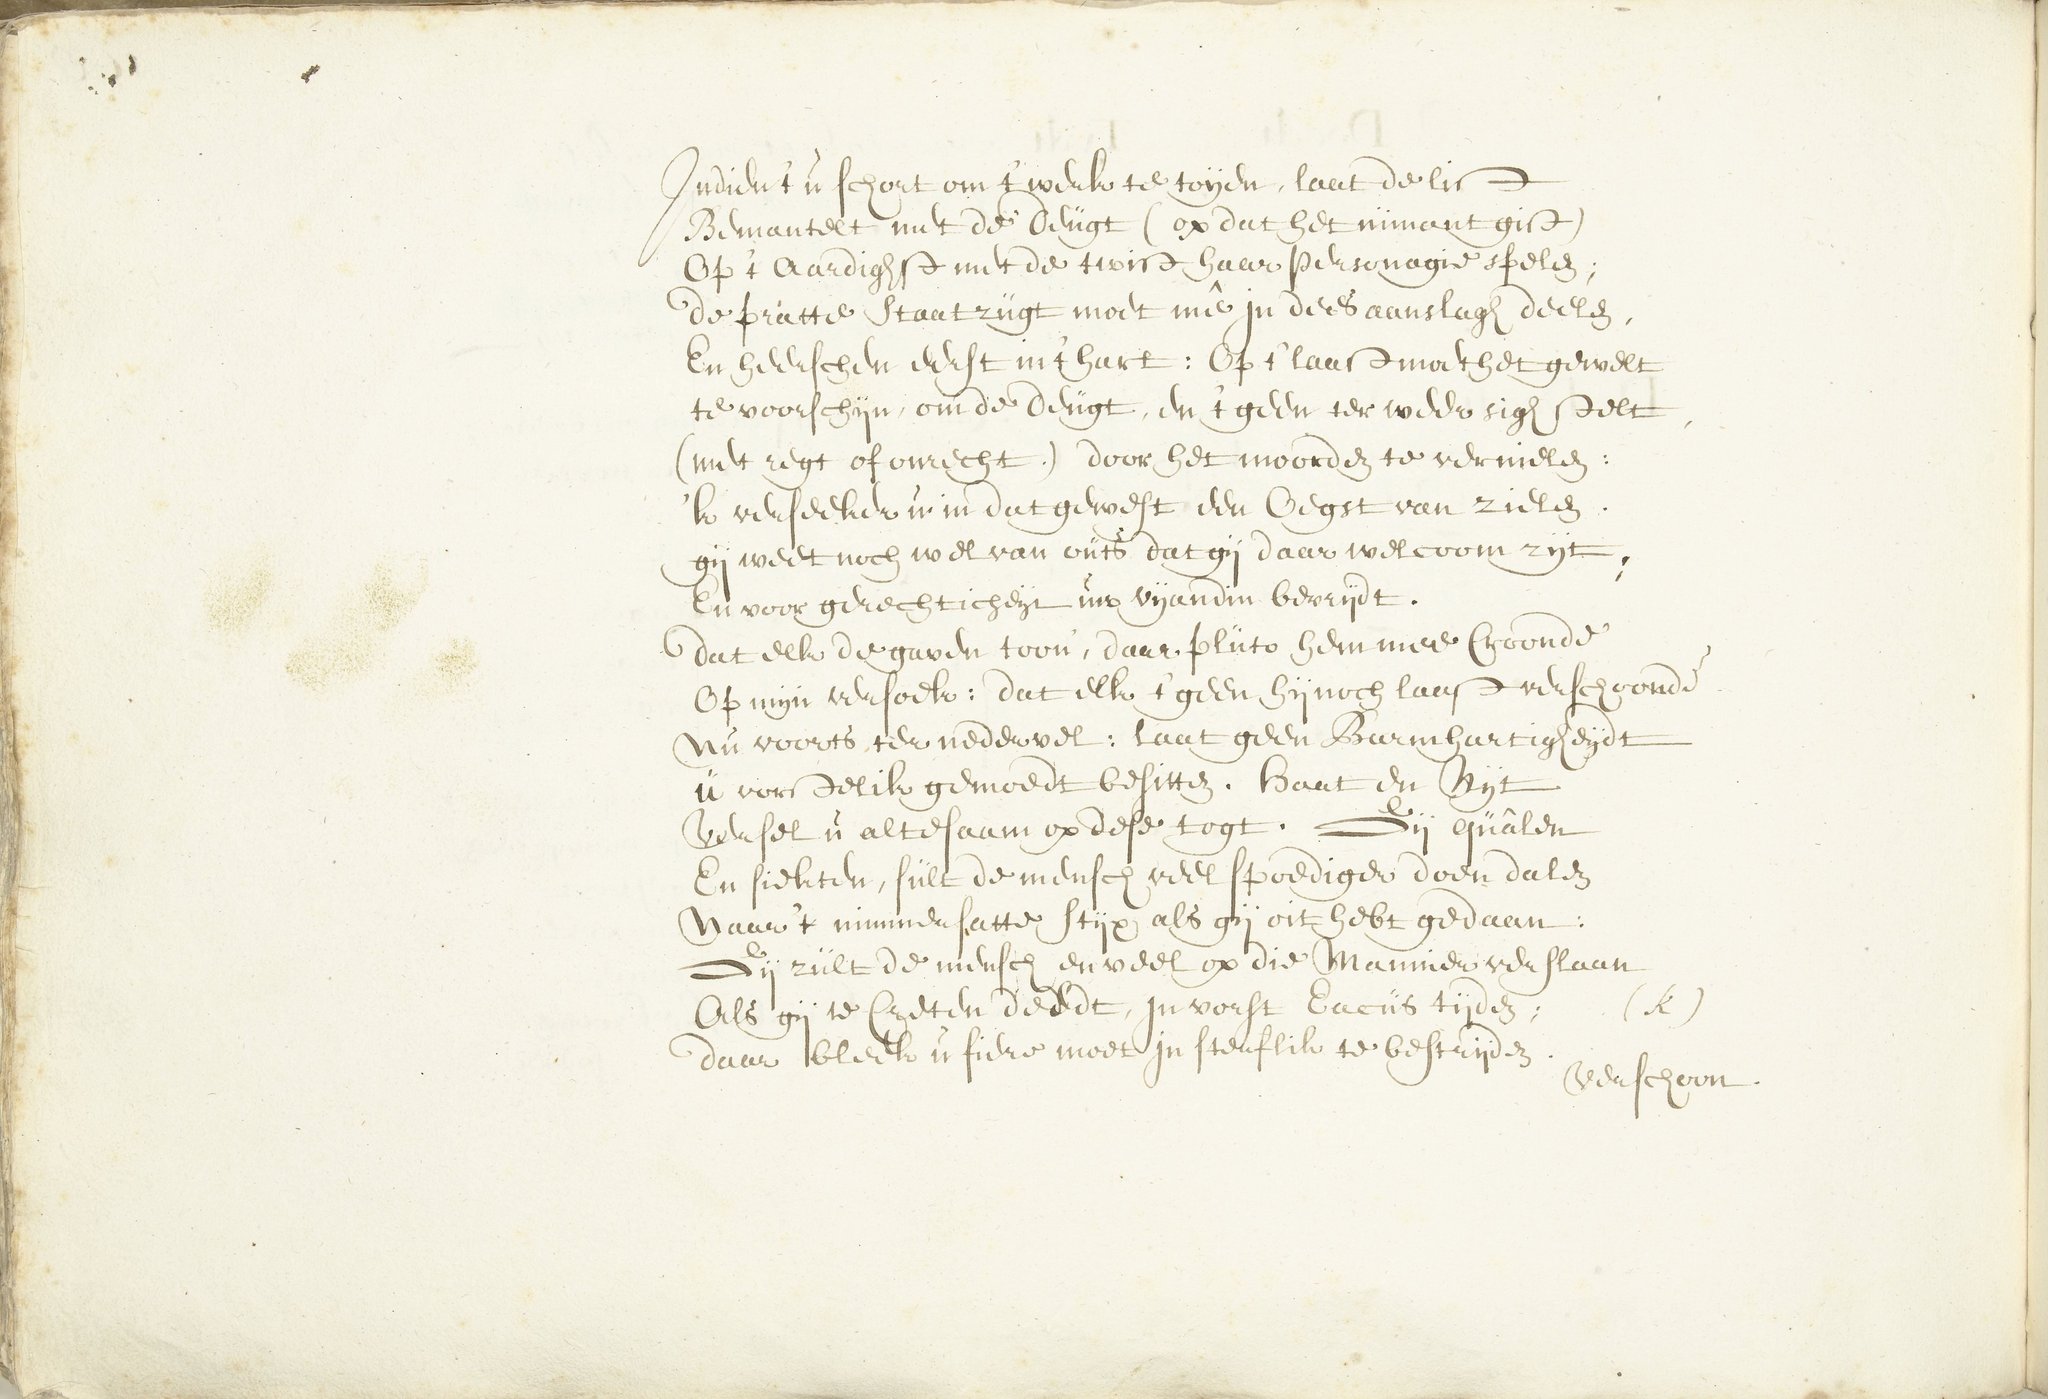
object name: text sheet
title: Strijd tussen Dood en Natuur of Zege der Schilderkunst (deel 12)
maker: henrik jordis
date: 1660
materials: ink, paper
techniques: writing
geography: zwolle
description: Vervolg van het toneelstuk Gooden Pleijdt ofte Triomphe der Schilderconst over de Doodt. In het toneelstuk beraden Apollo, Mercurius, Pallas Athene en Natuur zich over de manier waarop de Dood overwonnen kan worden en roepen zij de hulp van Schilderkunst in.